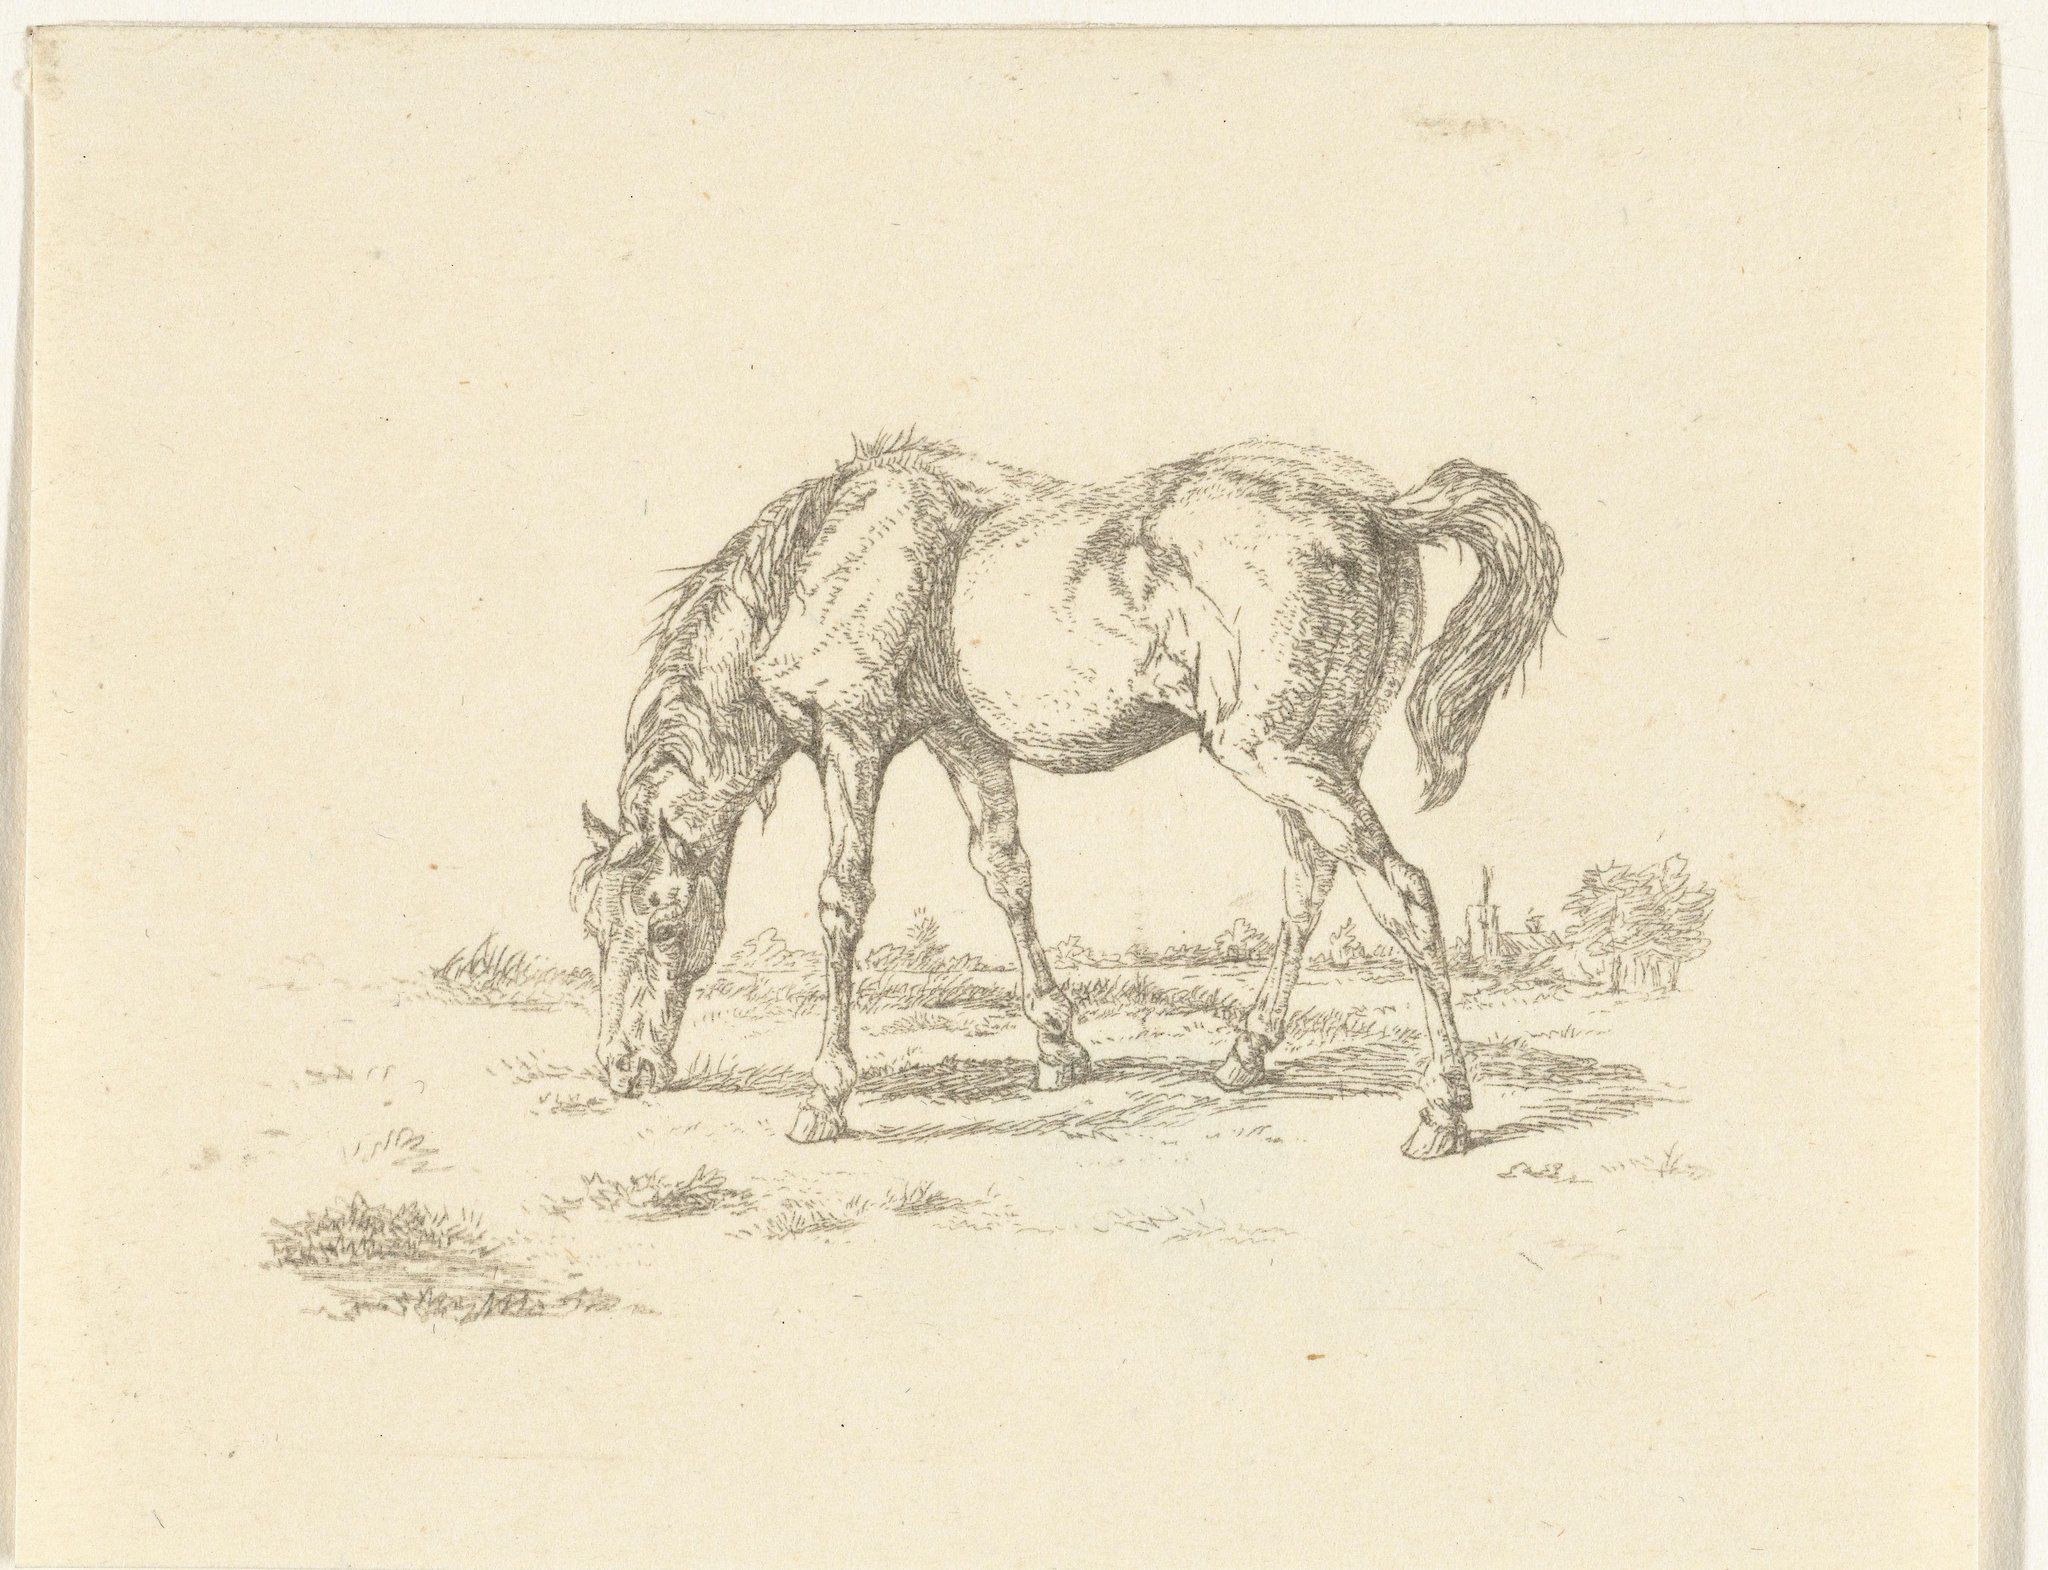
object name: print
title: Grazend paard naar rechts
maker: jan dasveldt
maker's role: draughtsman, print maker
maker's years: 1770-1855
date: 1780-1855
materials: paper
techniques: printmaking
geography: amsterdam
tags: horse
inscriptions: collector's mark: Lugt 2227, collector's mark: Lugt 1962